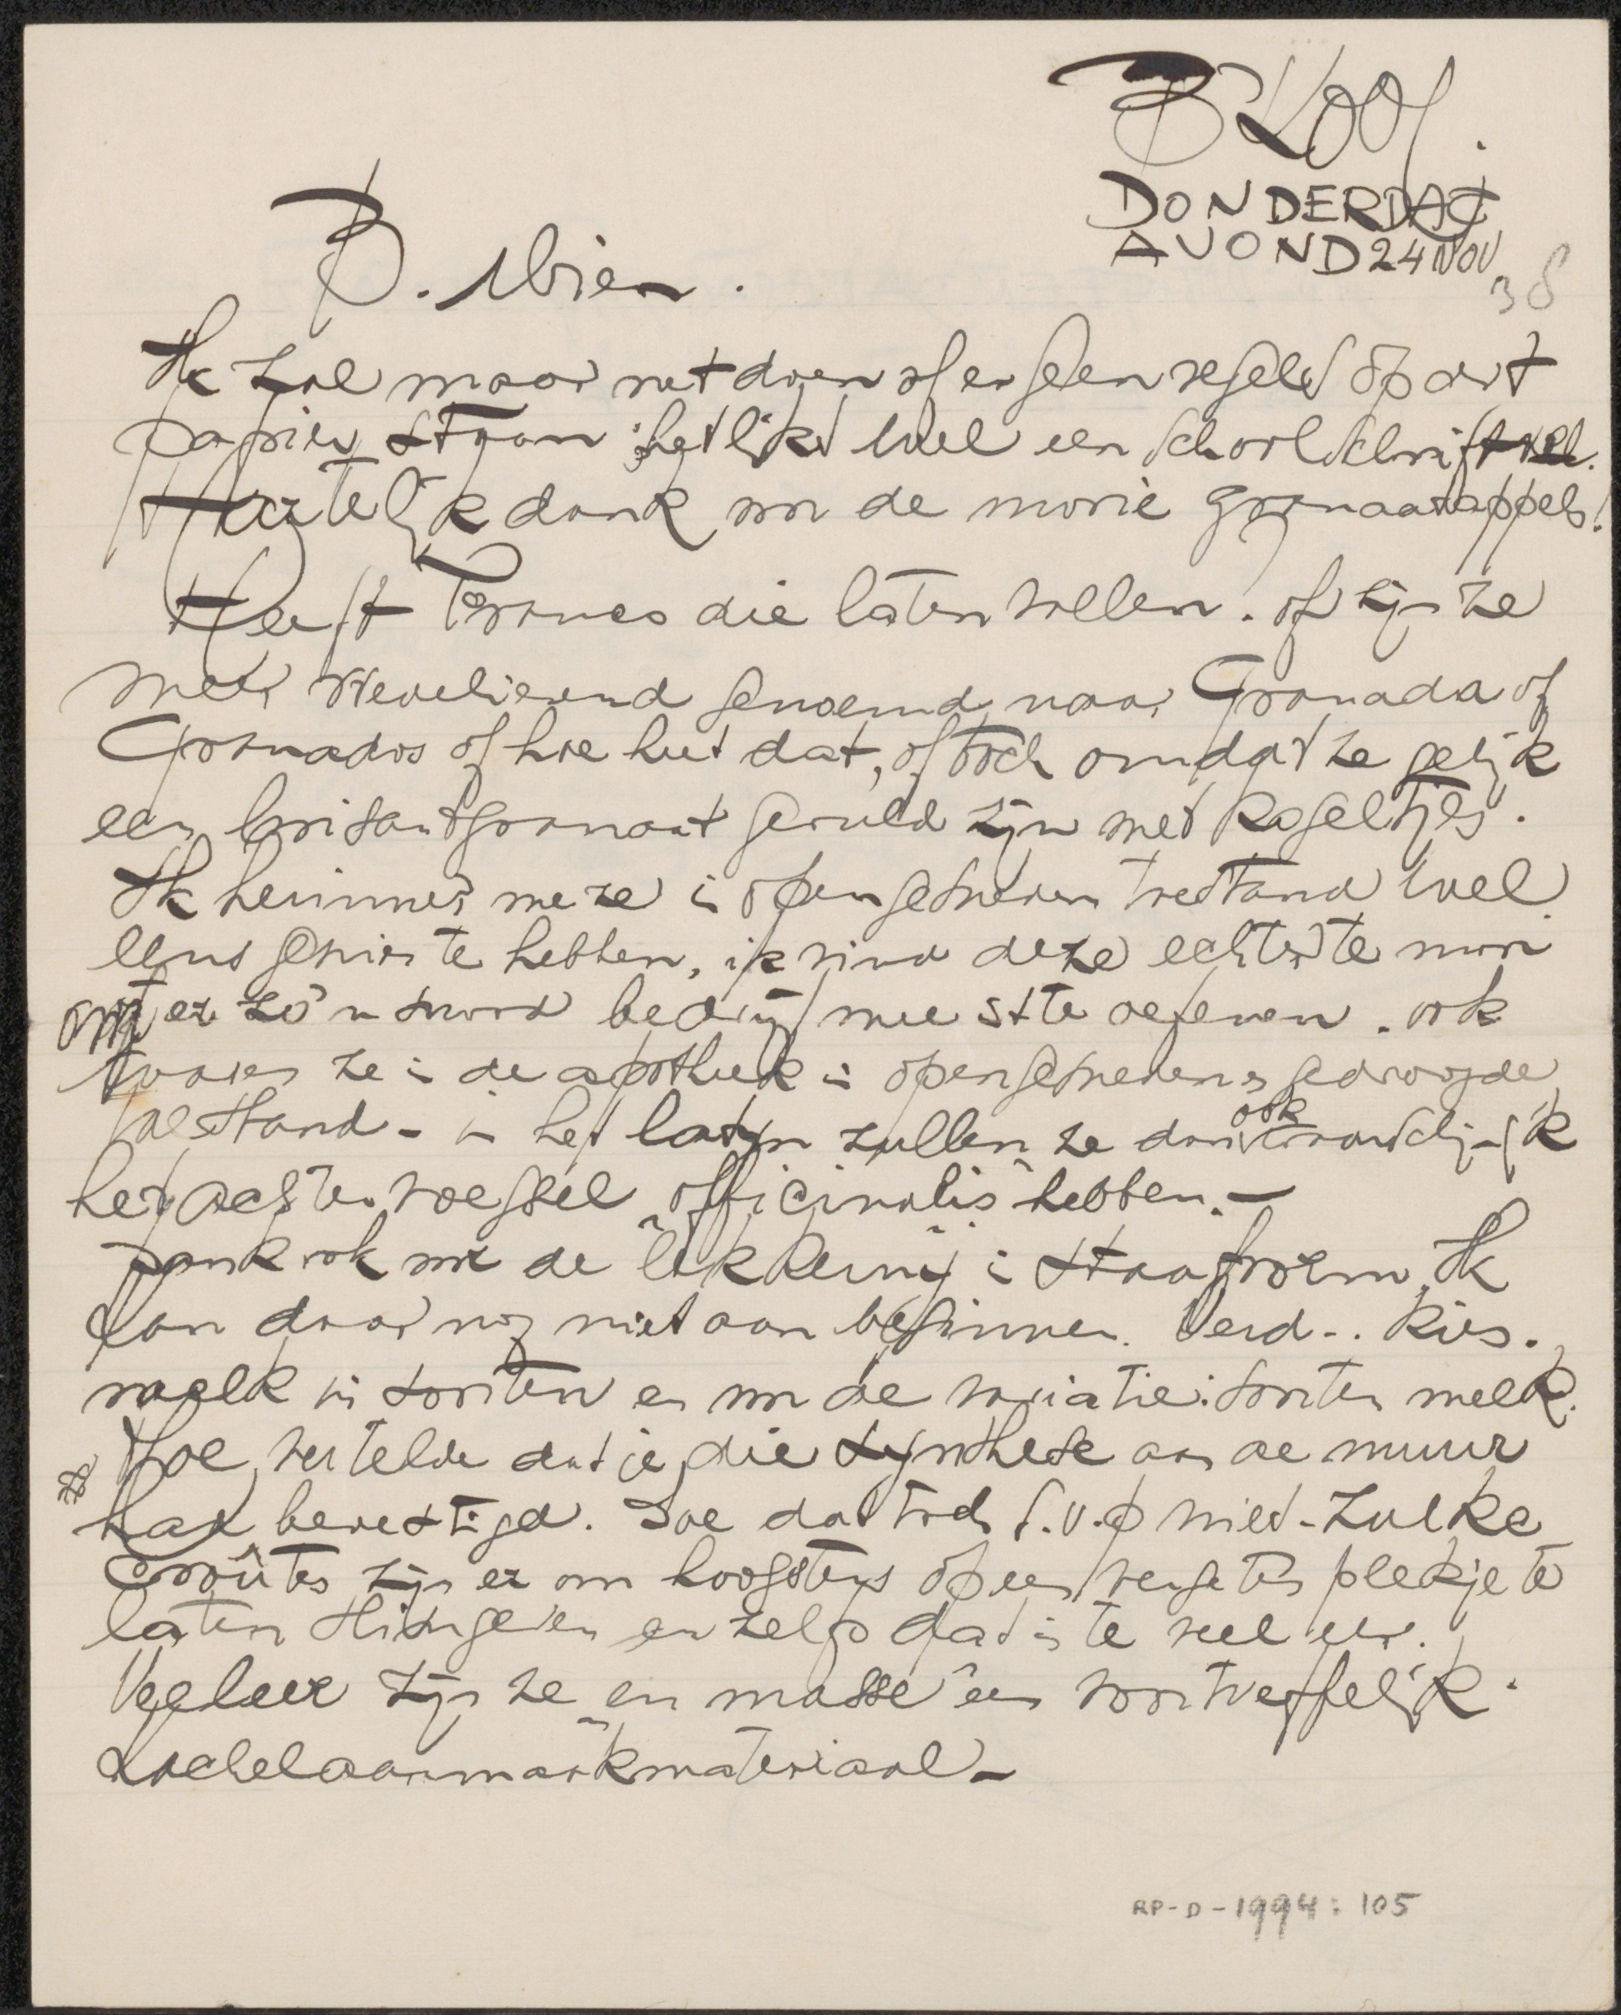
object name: letter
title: Brief aan Mien Cambier van Nooten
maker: dick ket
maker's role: draughtsman, print maker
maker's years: 1902-1940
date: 1912-1940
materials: ink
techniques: pen, writing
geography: bennekom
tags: mien cambier van nooten, jan greshoff, charles eyck, dollmaker, textile artist, nelly johanna hagelen-schilt, sleeping in chair, literature ~ arts, diseases, historical persons (portraits and scenes from the life)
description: Brief gedateerd 24 november door schrijver, 1938 in latere hand.